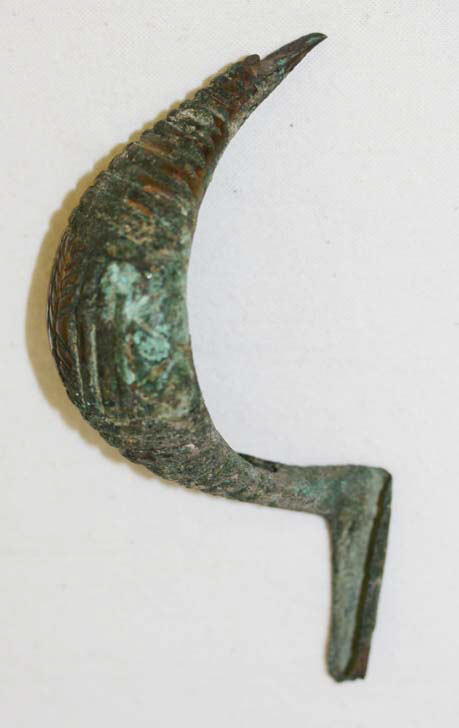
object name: pin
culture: european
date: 400-301 BCE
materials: bronze